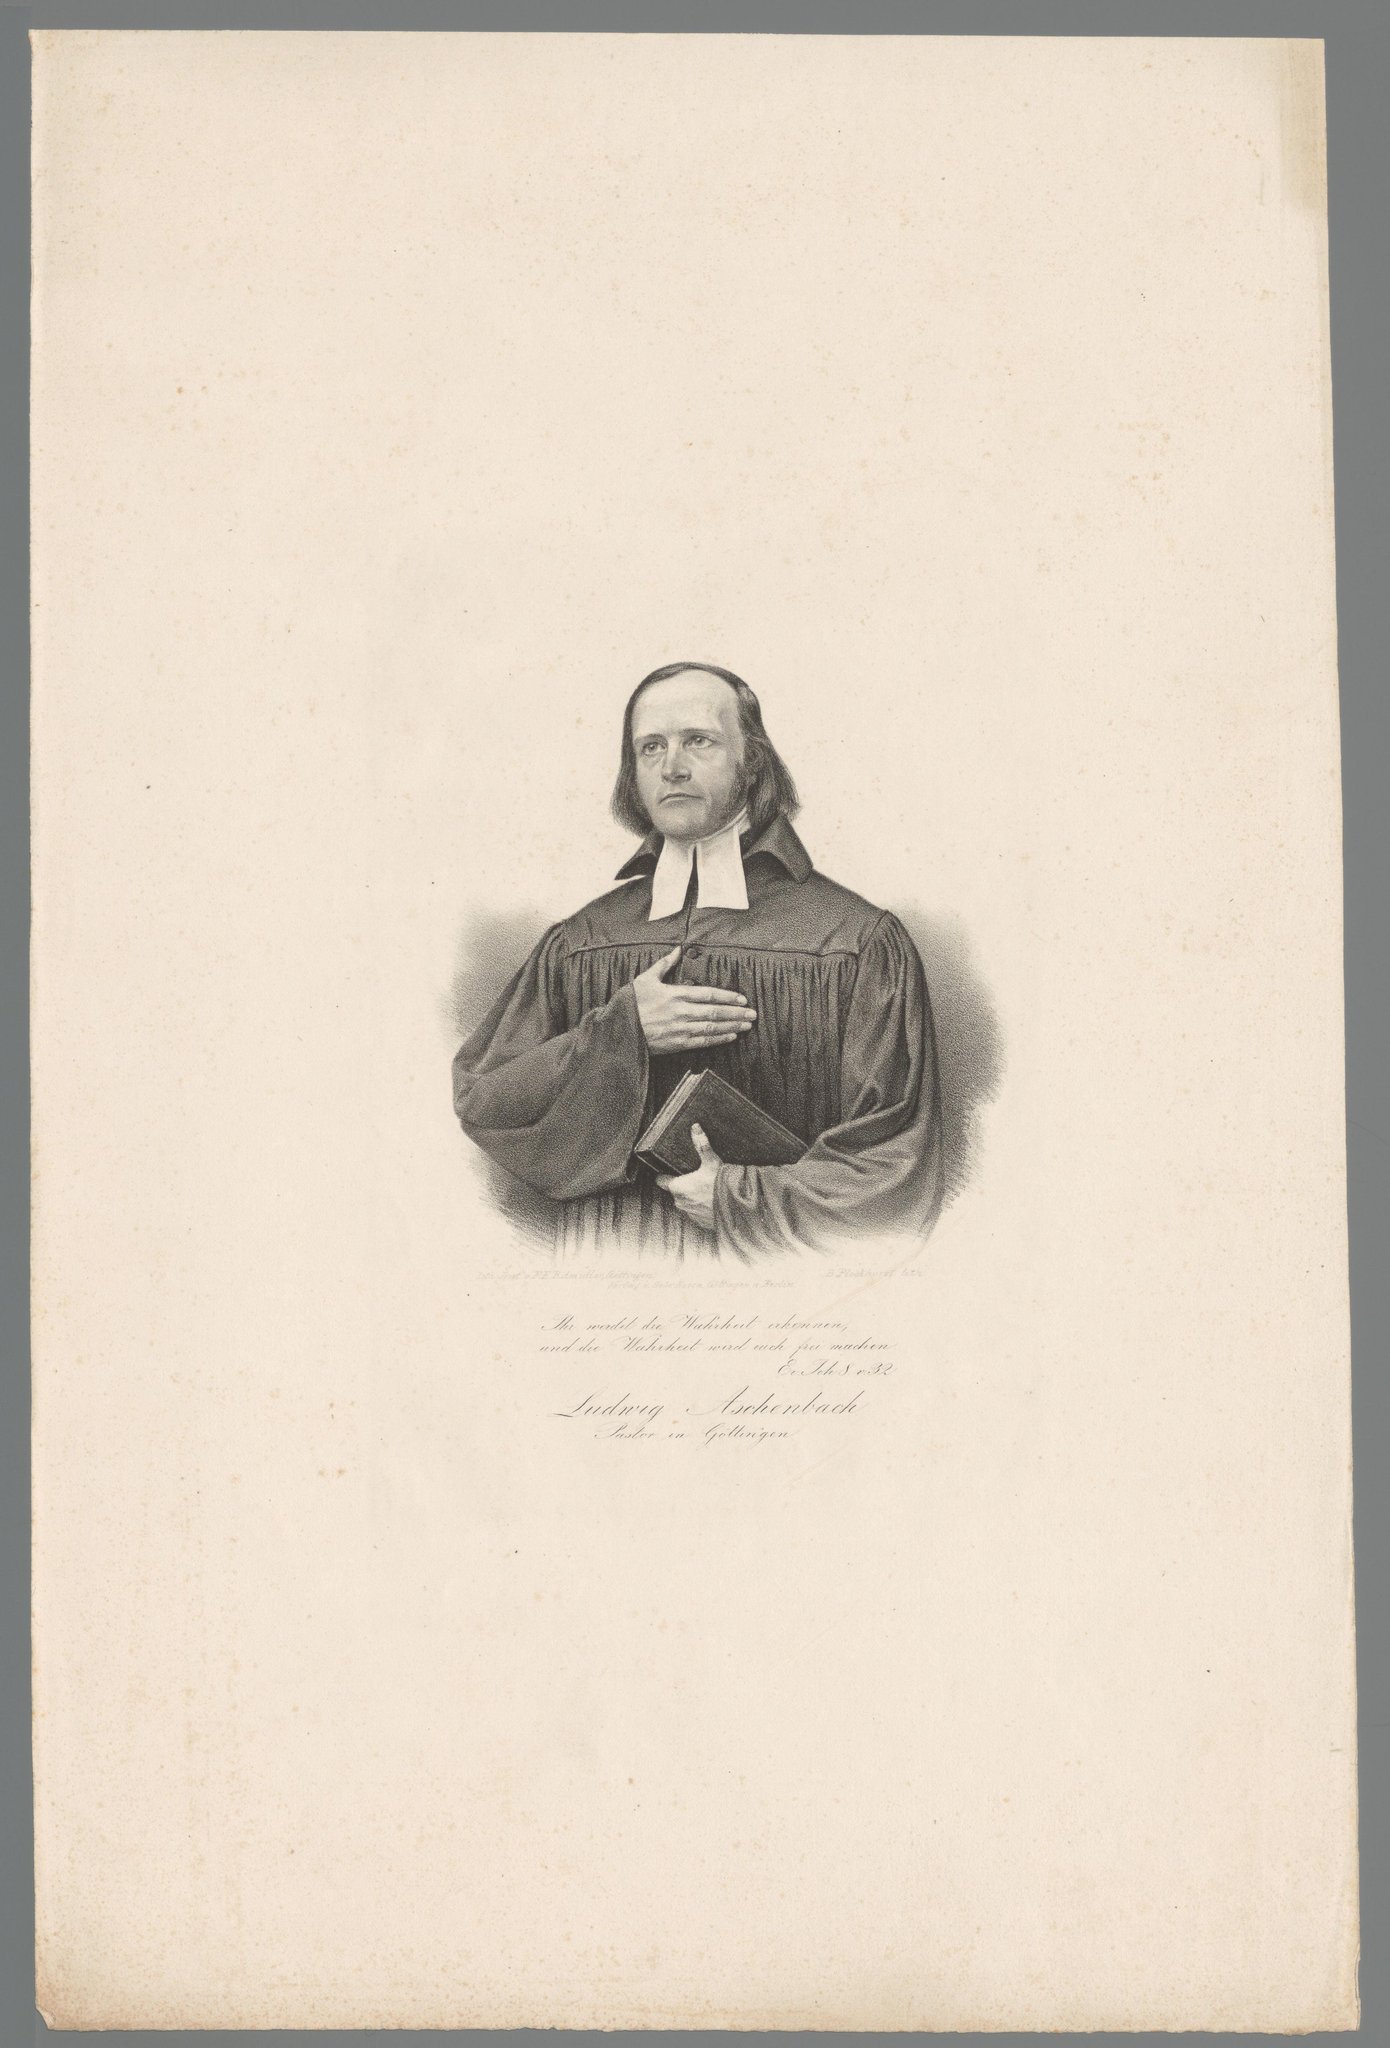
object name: print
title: Portret van Ludwig Aschenbach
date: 1835-1874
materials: paper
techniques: lithograph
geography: gottingen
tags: hierarchy of jurisdiction ~ roman catholic church, adult man, historical persons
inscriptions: collector's mark: Lugt 2228